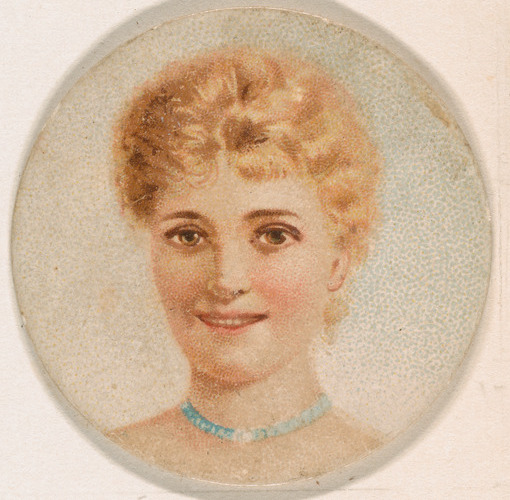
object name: print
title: Portrait of woman, from the Novelties series (N228, Type 1) issued by Kinney Bros.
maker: kinney brothers tobacco company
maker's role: publisher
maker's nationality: american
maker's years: 1869-2011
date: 1889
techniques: color lithograph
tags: portraits,women